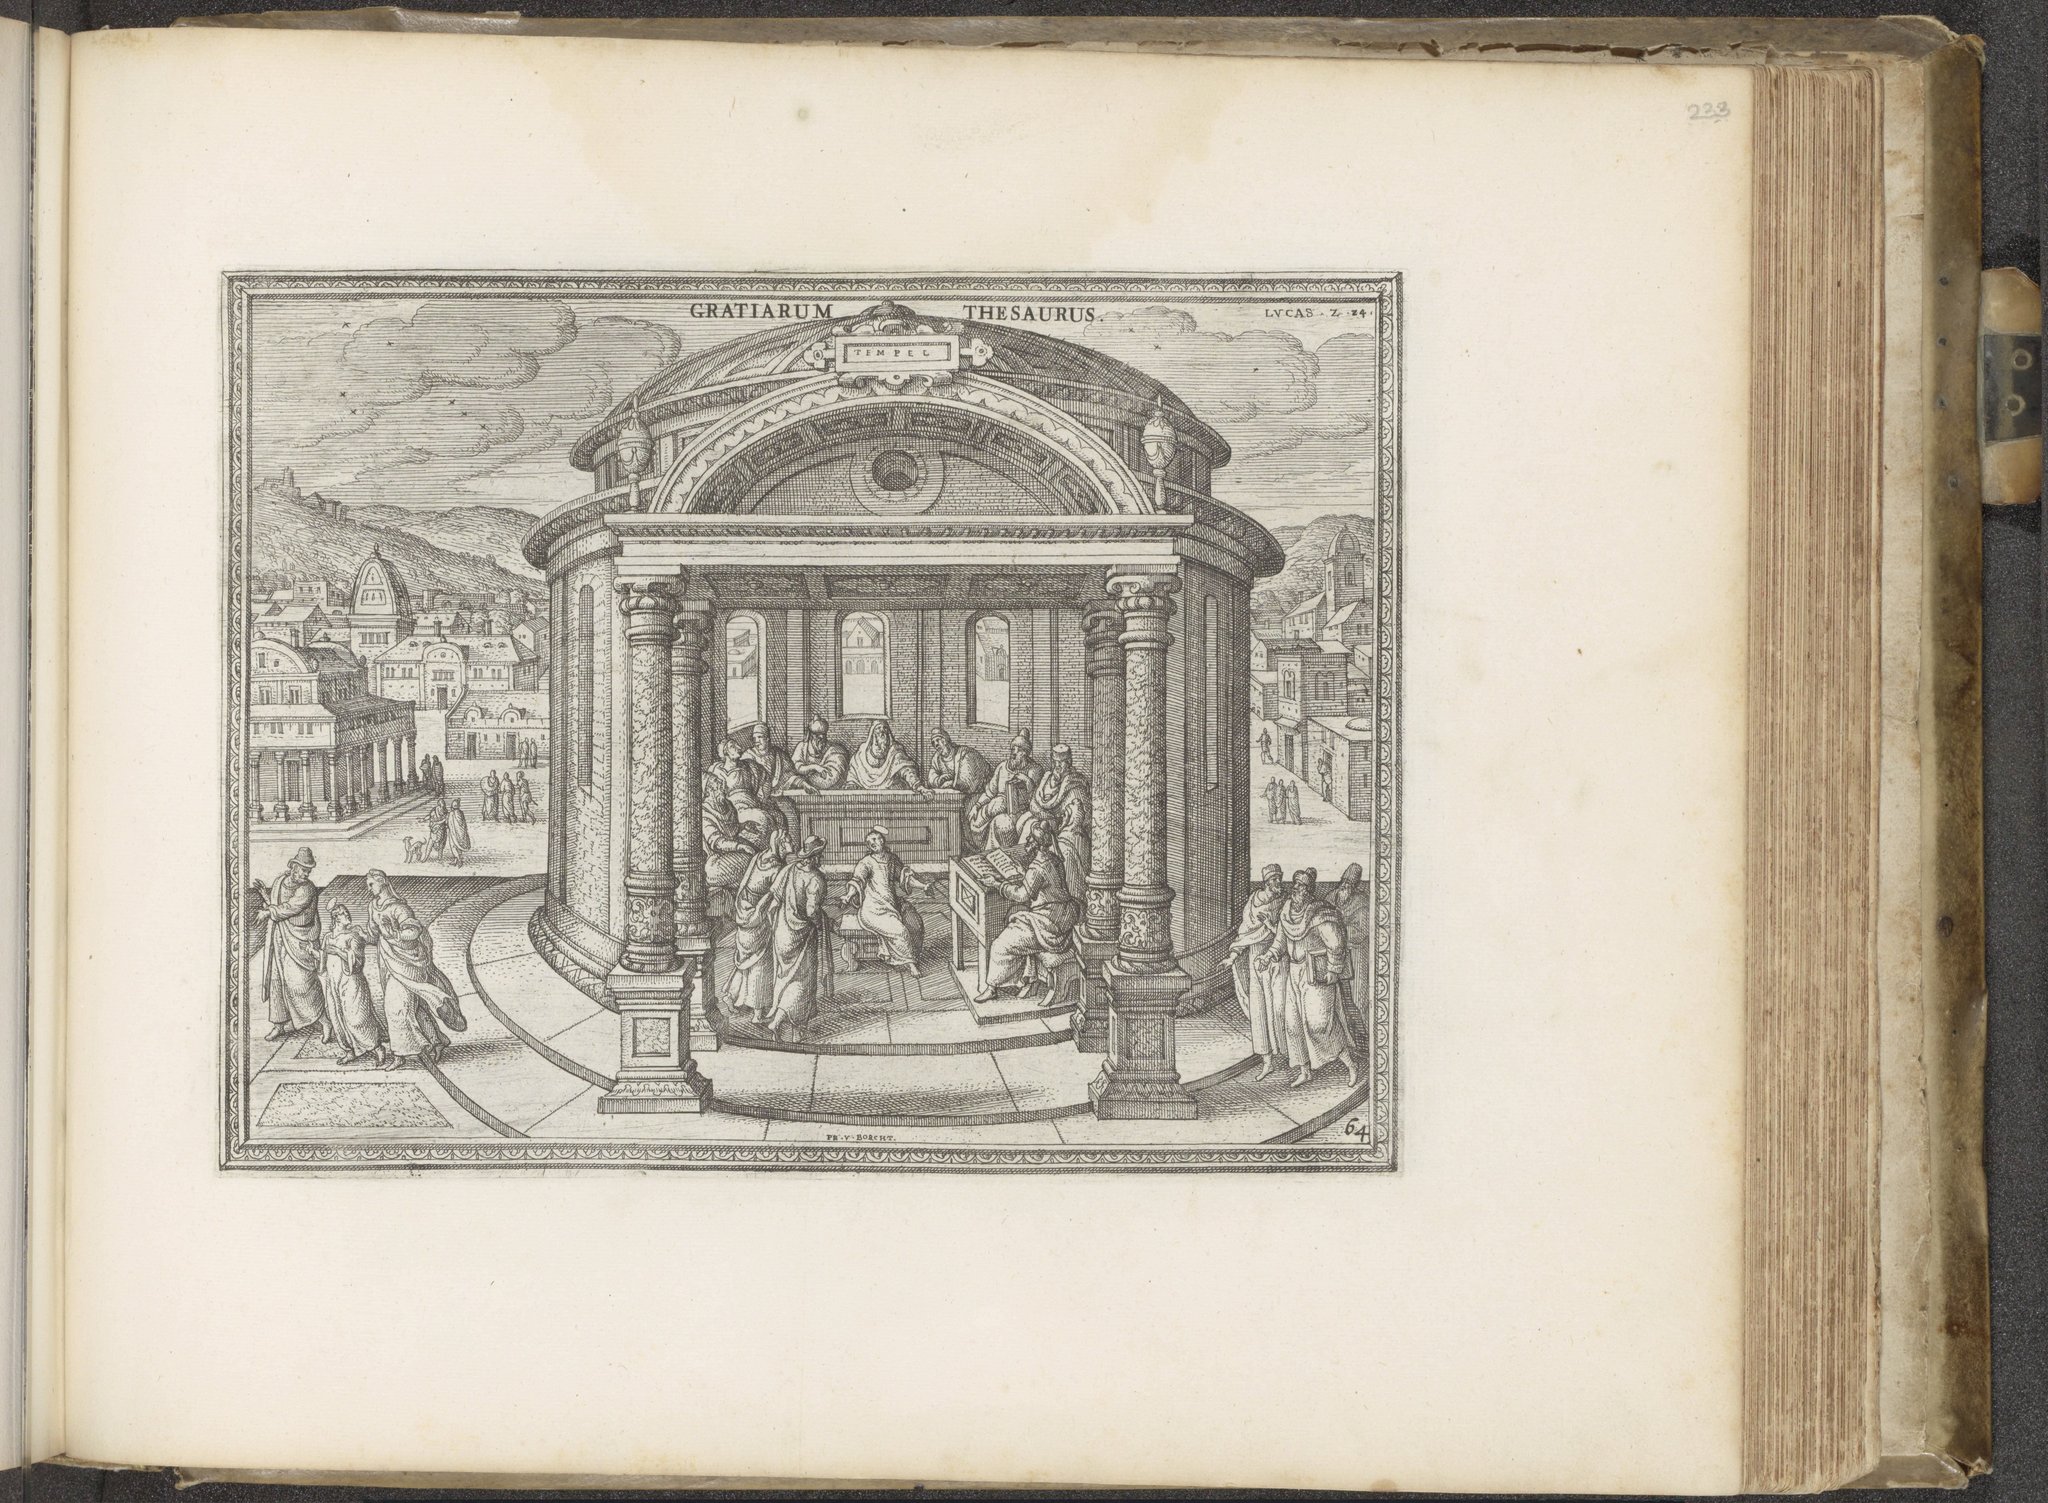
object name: print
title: Gratiarum thesaurus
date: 1582-1593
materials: paper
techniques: etching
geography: amsterdam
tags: christ's dispute with the doctors in the temple; he counts his arguments on his fingers, christ returning with his parents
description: Christus tussen de schriftgeleerden in de tempel. Links op de prent nemen Jozef en Maria hun zoon mee naar Nazaret. De prent maakt deel uit van een album.